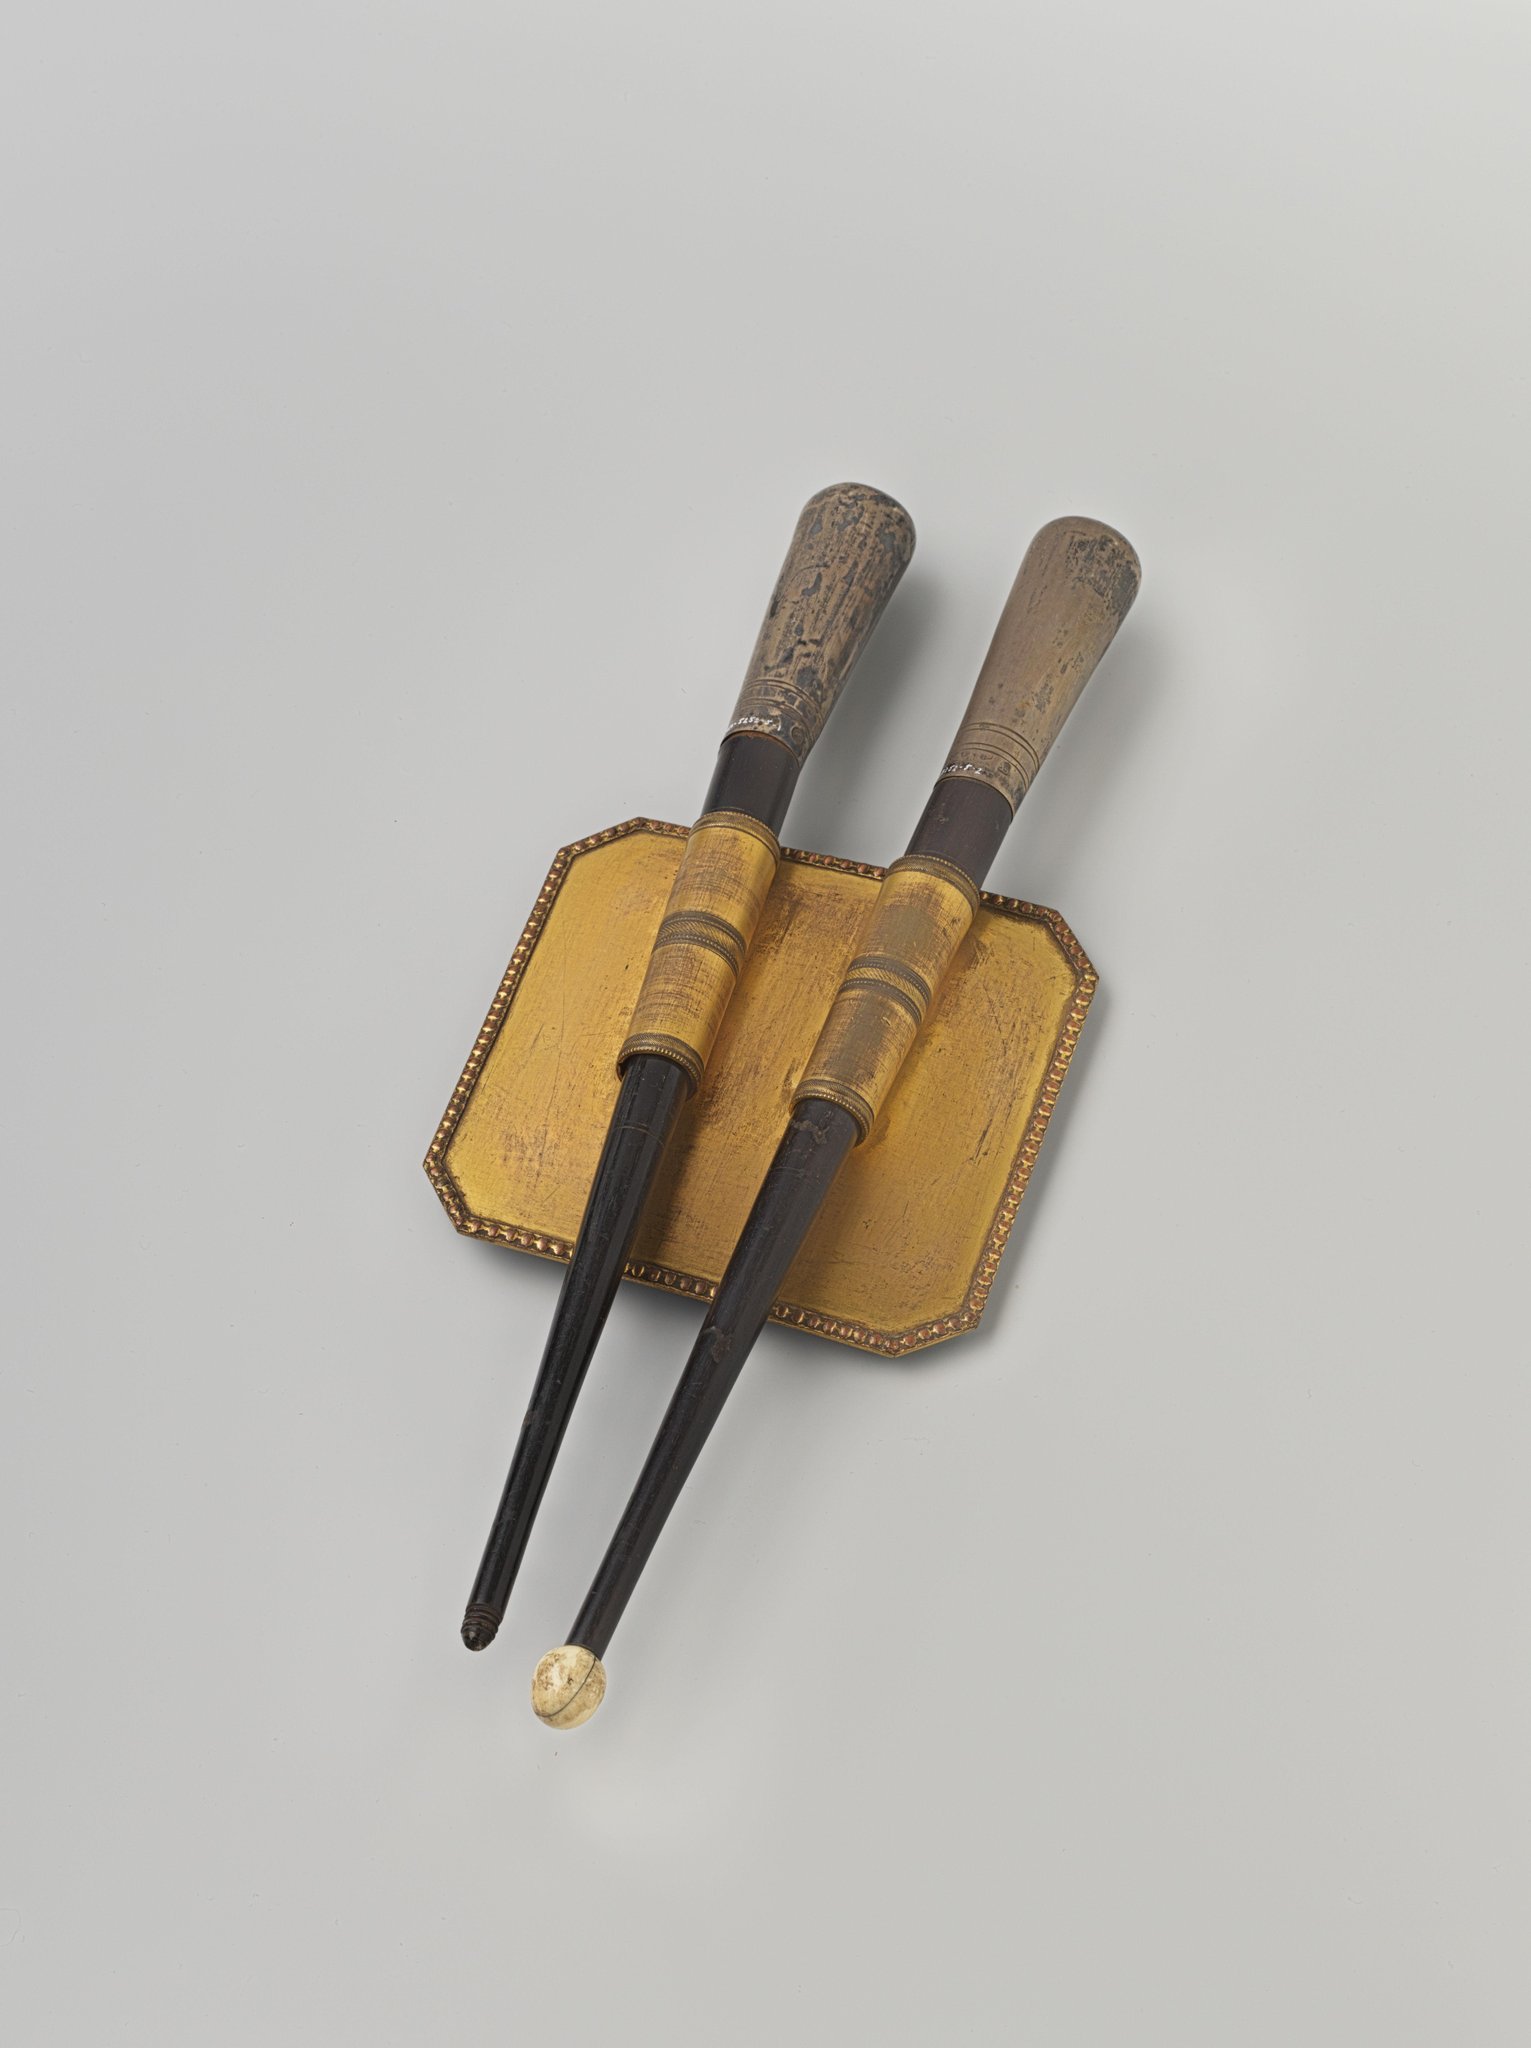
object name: percussion instrument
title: Drumsticks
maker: Anonymous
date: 1817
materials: wood, ivory, silver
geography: netherlands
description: Een ebbenhouten tromstok met ivoren knop. Een knop ontbreekt. Stokken bezet met zilveren bussen.